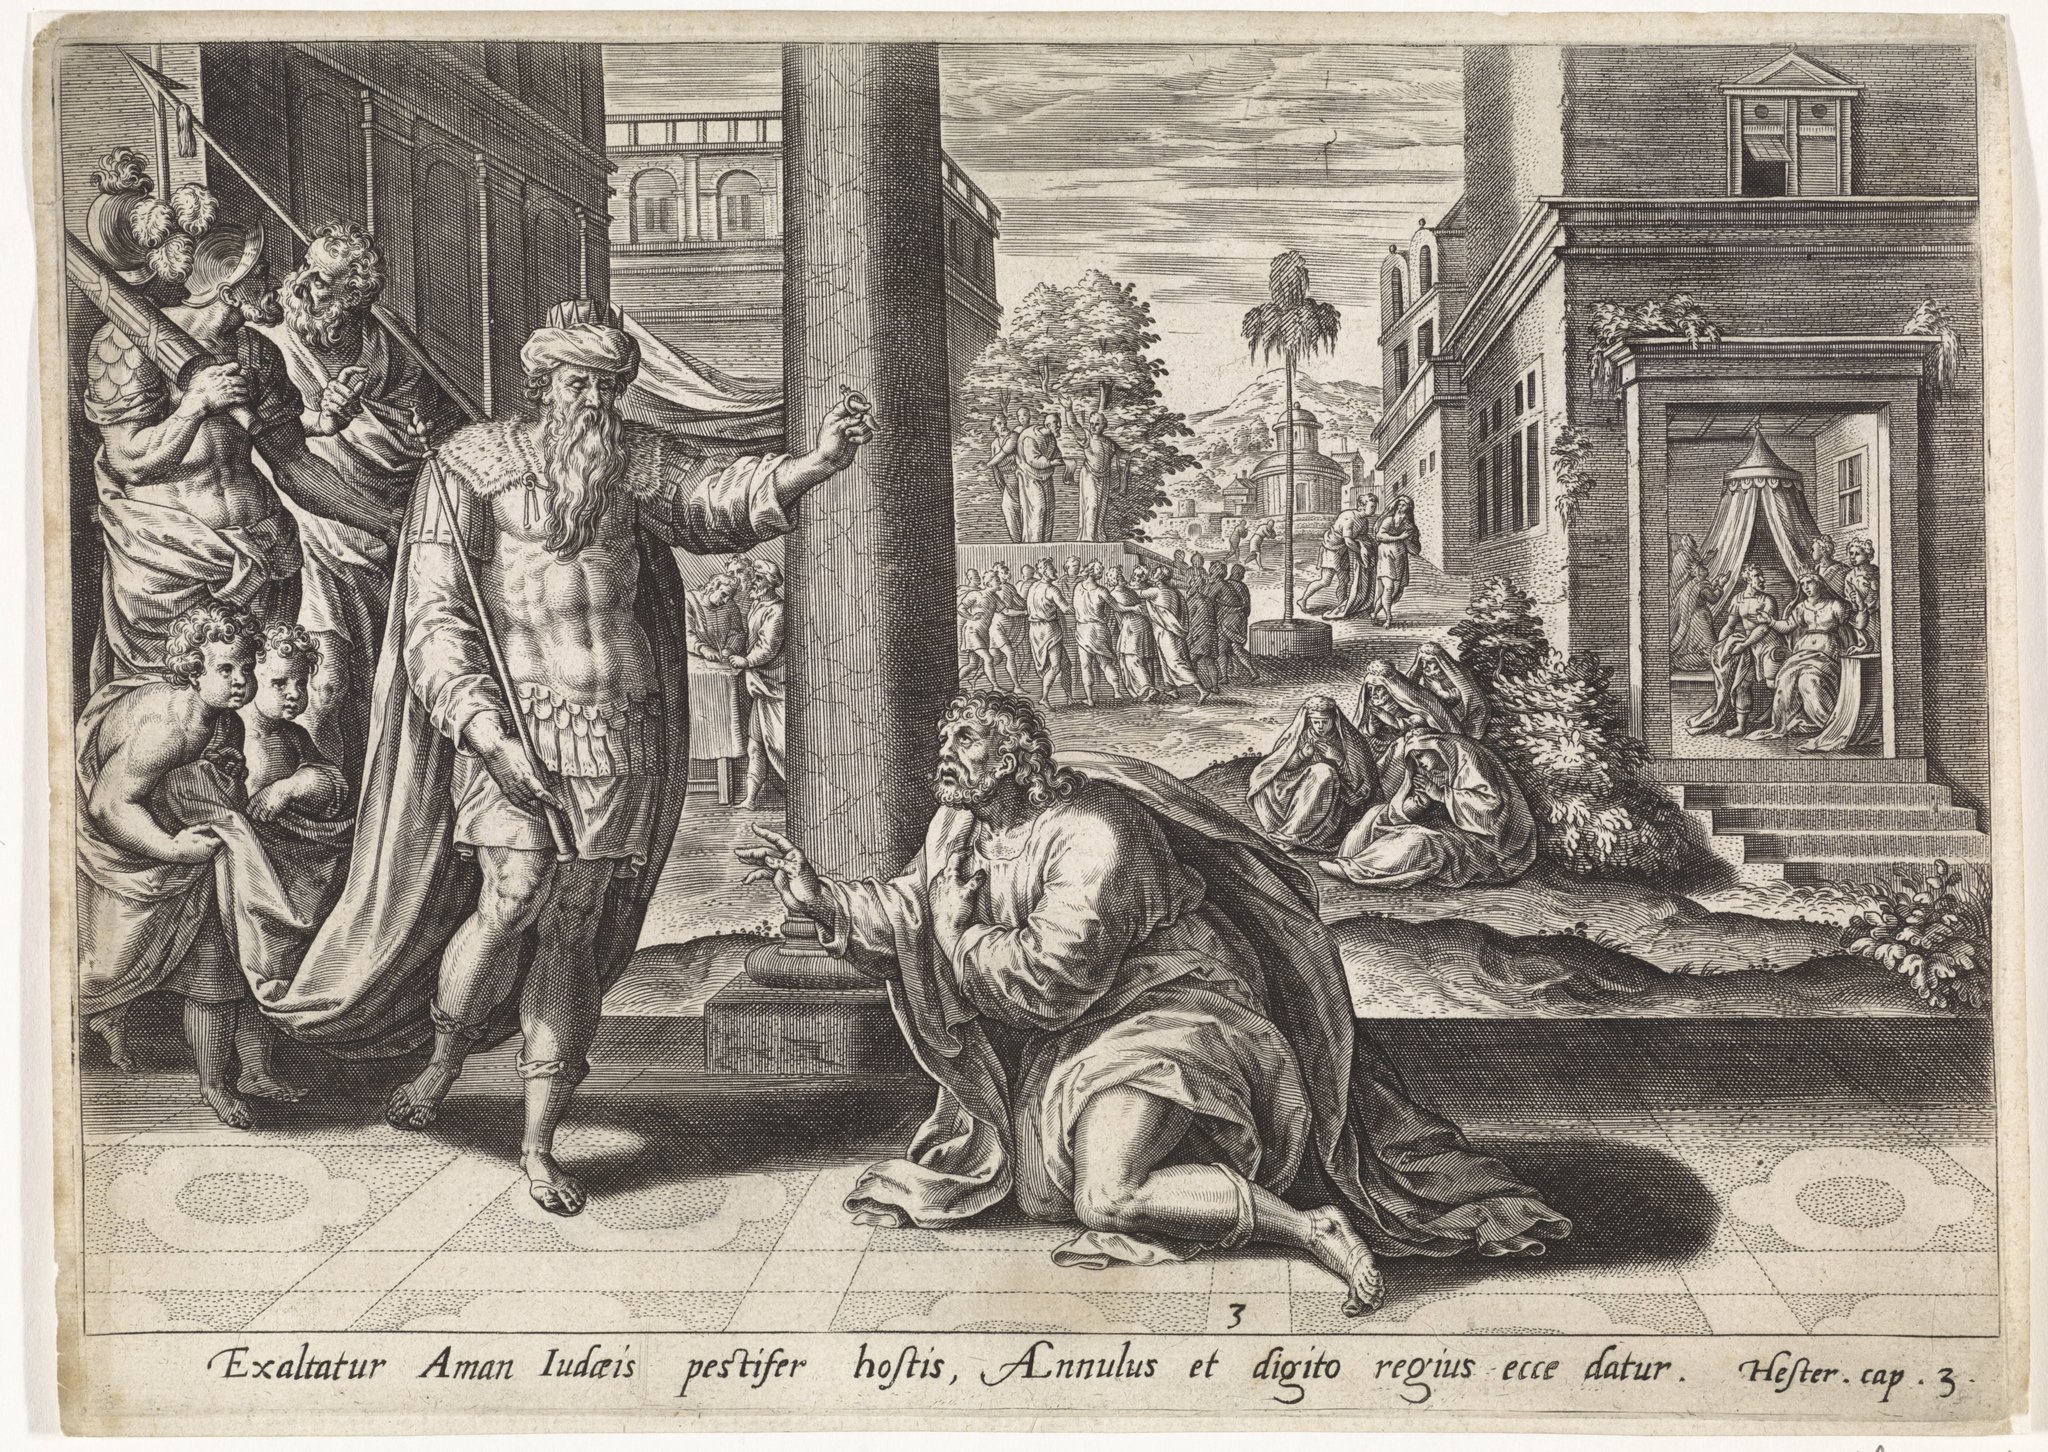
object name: print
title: Thesaurus sacrarum historiarum veteris testamenti (...)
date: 1579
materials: paper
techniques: engraving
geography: antwerp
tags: mourning, prayer and distress of esther (esther 14), the jews mourn throughout the kingdom, a royal decree is issued and sent throughout the country ~ haman's plot against the jews, haman entreats ahasuerus to issue a decree that all the jews are to be put to death; ahasuerus consents and yields his signet-ring to haman, esther sends mordecai some clothes; he refuses them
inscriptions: collector's mark: Lugt 2760, collector's mark: Lugt 2228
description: Koning Ahasveros geeft zijn zegelring aan Haman, waarmee Haman uit naam van de koning zijn plan kan laten uitvoeren om alle Joden ter dood te laten brengen. Op de achtergrond wordt het besluit verkondigd. Een groepje Joden zit te treuren met as op het hoofd. Rechts koningin Ester in haar vertrek waar ze een dienaar de opdracht geeft om Mordechai kleren te brengen zodat hij die kan dragen in plaats van zijn rouwkleed. Links naast het gebouw weigert Mordechai de kleren te aanvaarden. Nog verder op de achtergrond bidt Ester om een goede afloop. Onder de voorstelling een verwijzing in het Latijn naar de Bijbeltekst in Est. 3.